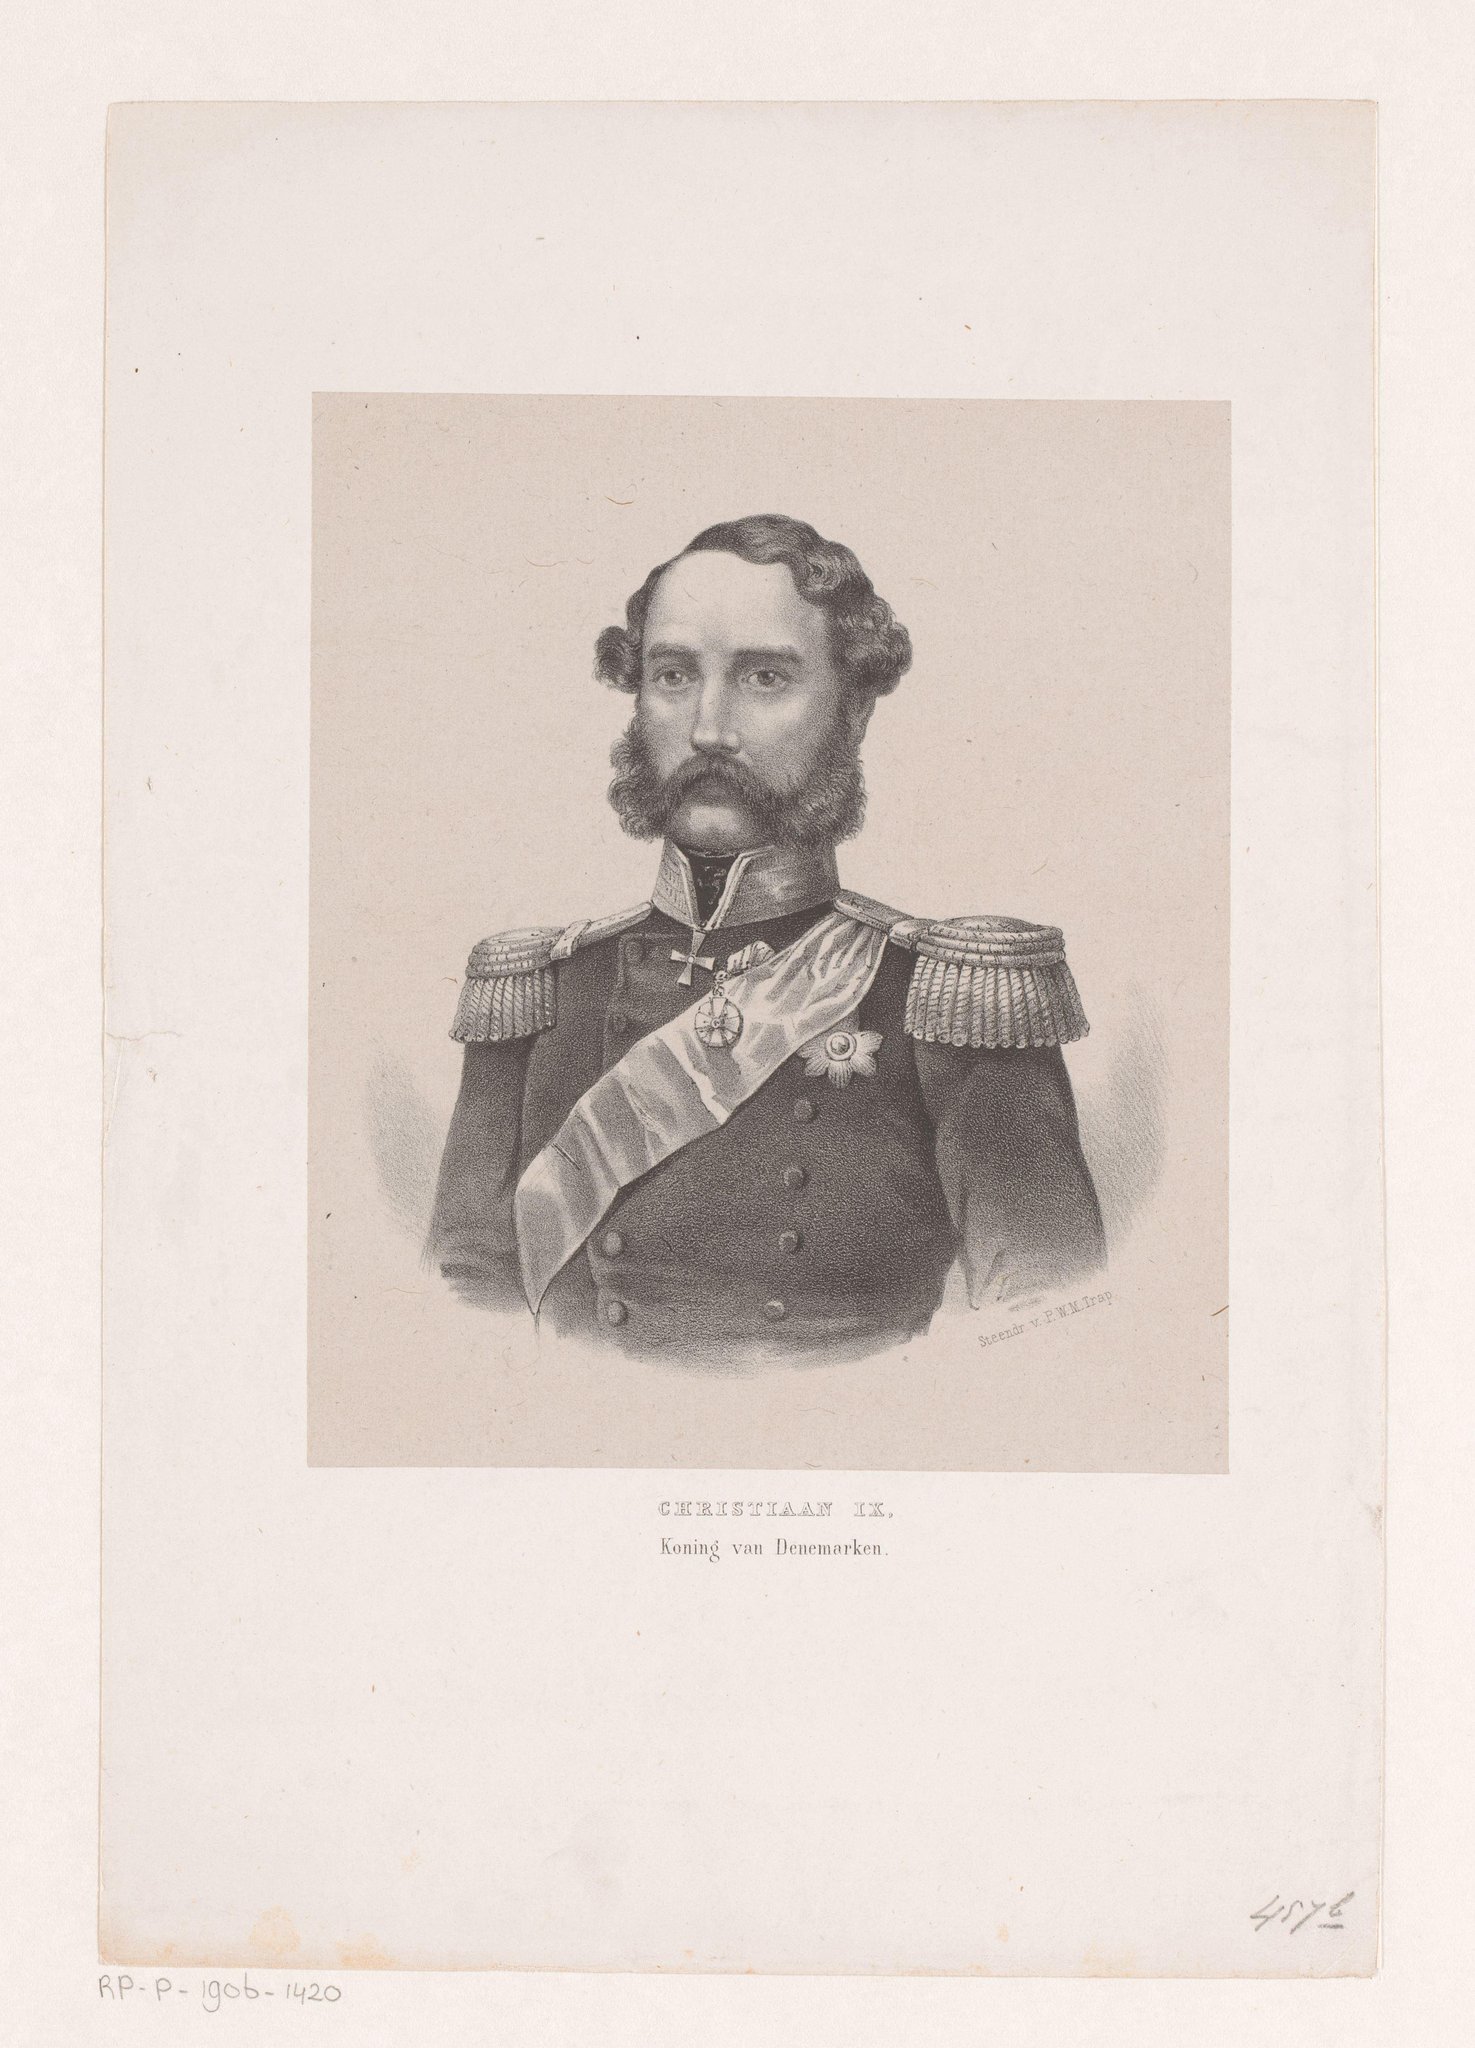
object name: print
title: Christiaan IX. Koning van Denemarken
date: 1836-1905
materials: paper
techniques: lithograph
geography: leiden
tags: historical persons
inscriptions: collector's mark: Lugt 2228